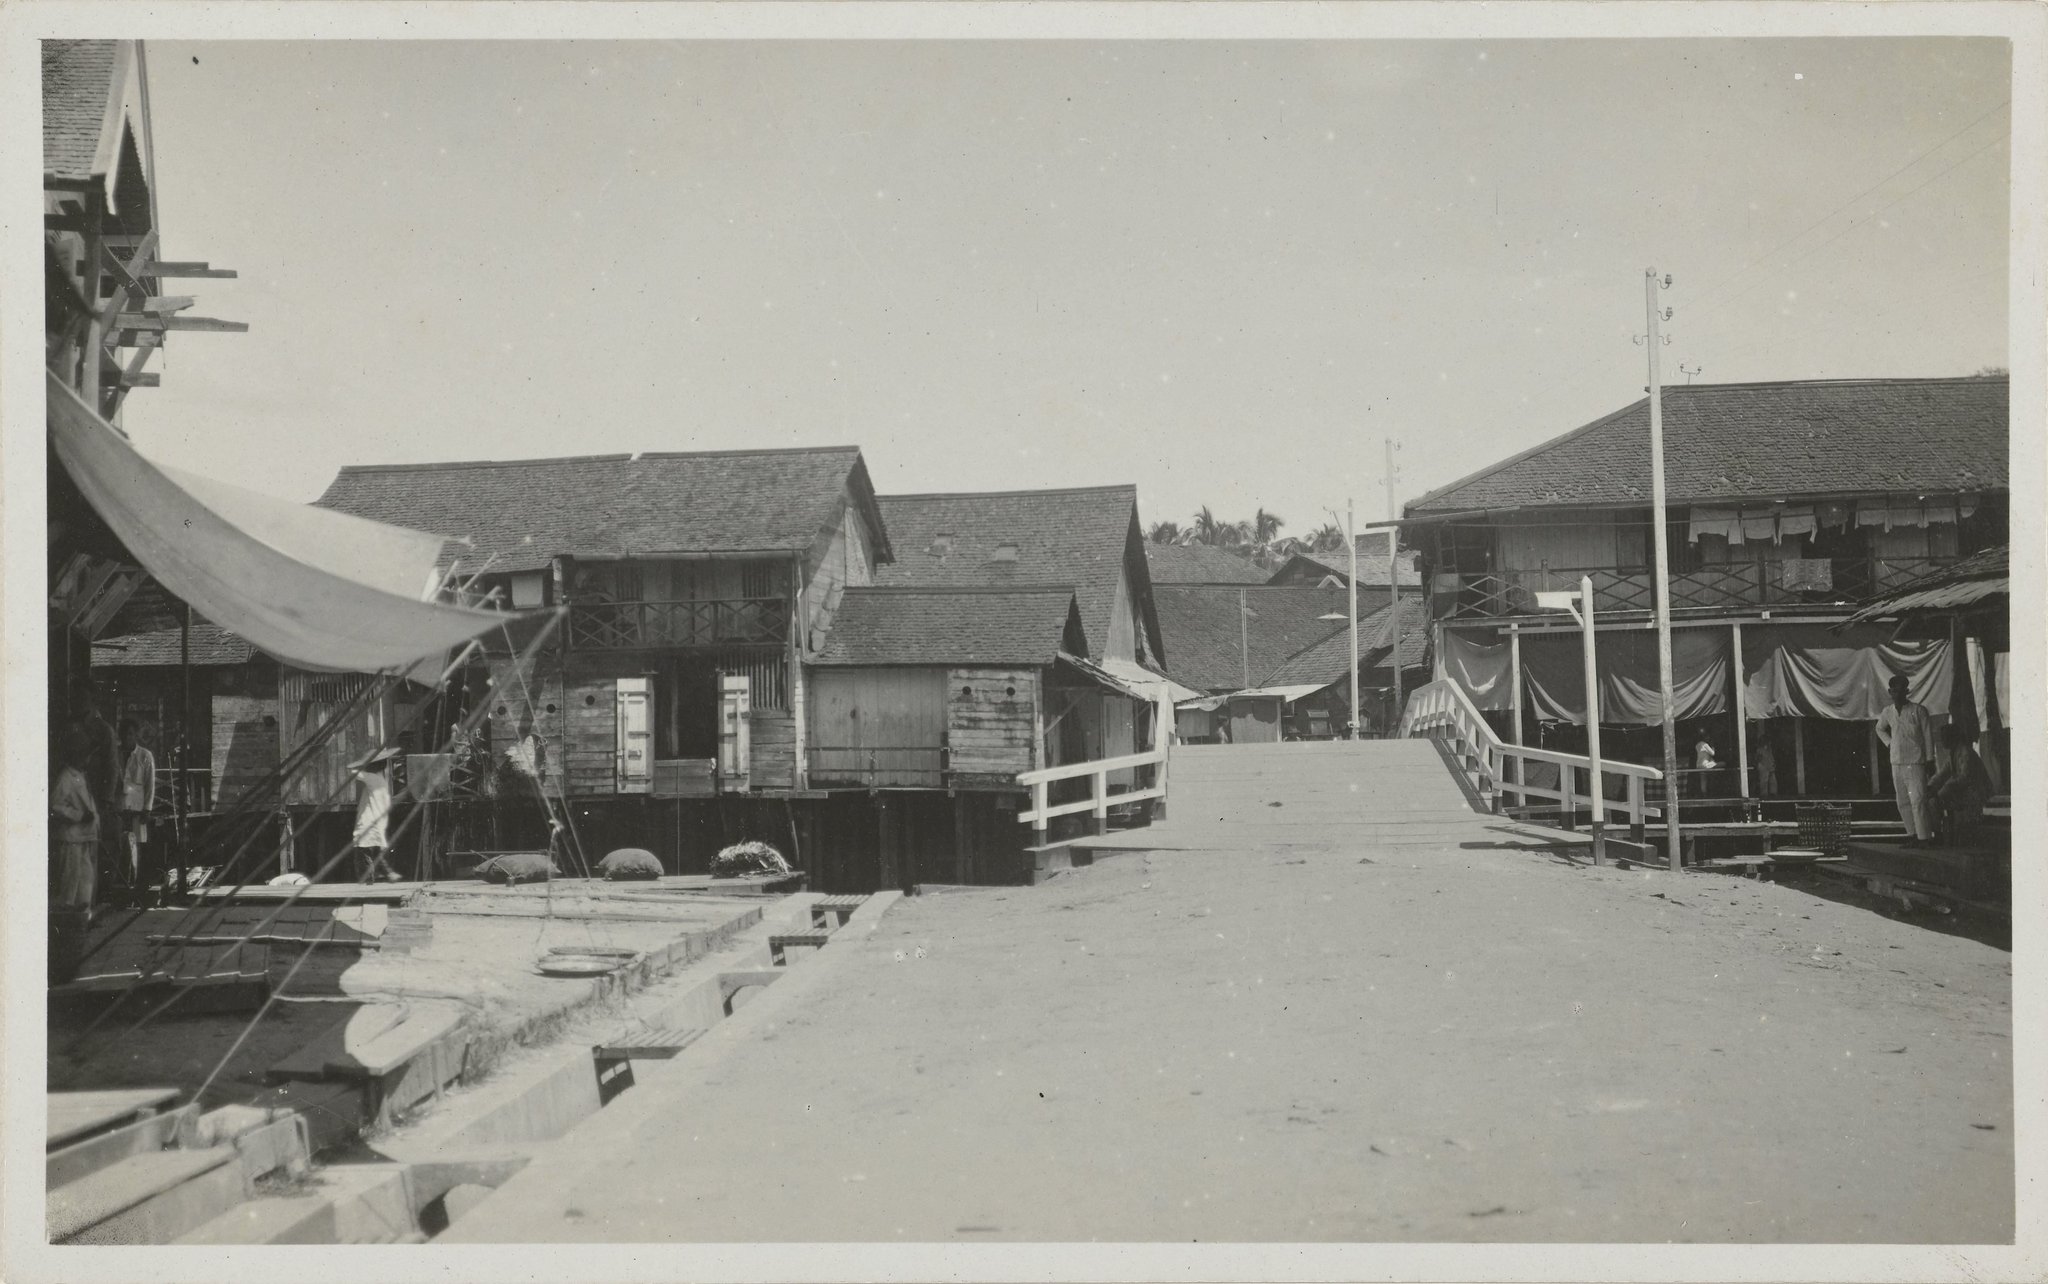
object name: ansichtkaart, prentbriefkaart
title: Singkawang, brug bij passar Sebrang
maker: Anonymous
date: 1920-1940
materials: photographic support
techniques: gelatin silver print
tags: borneo